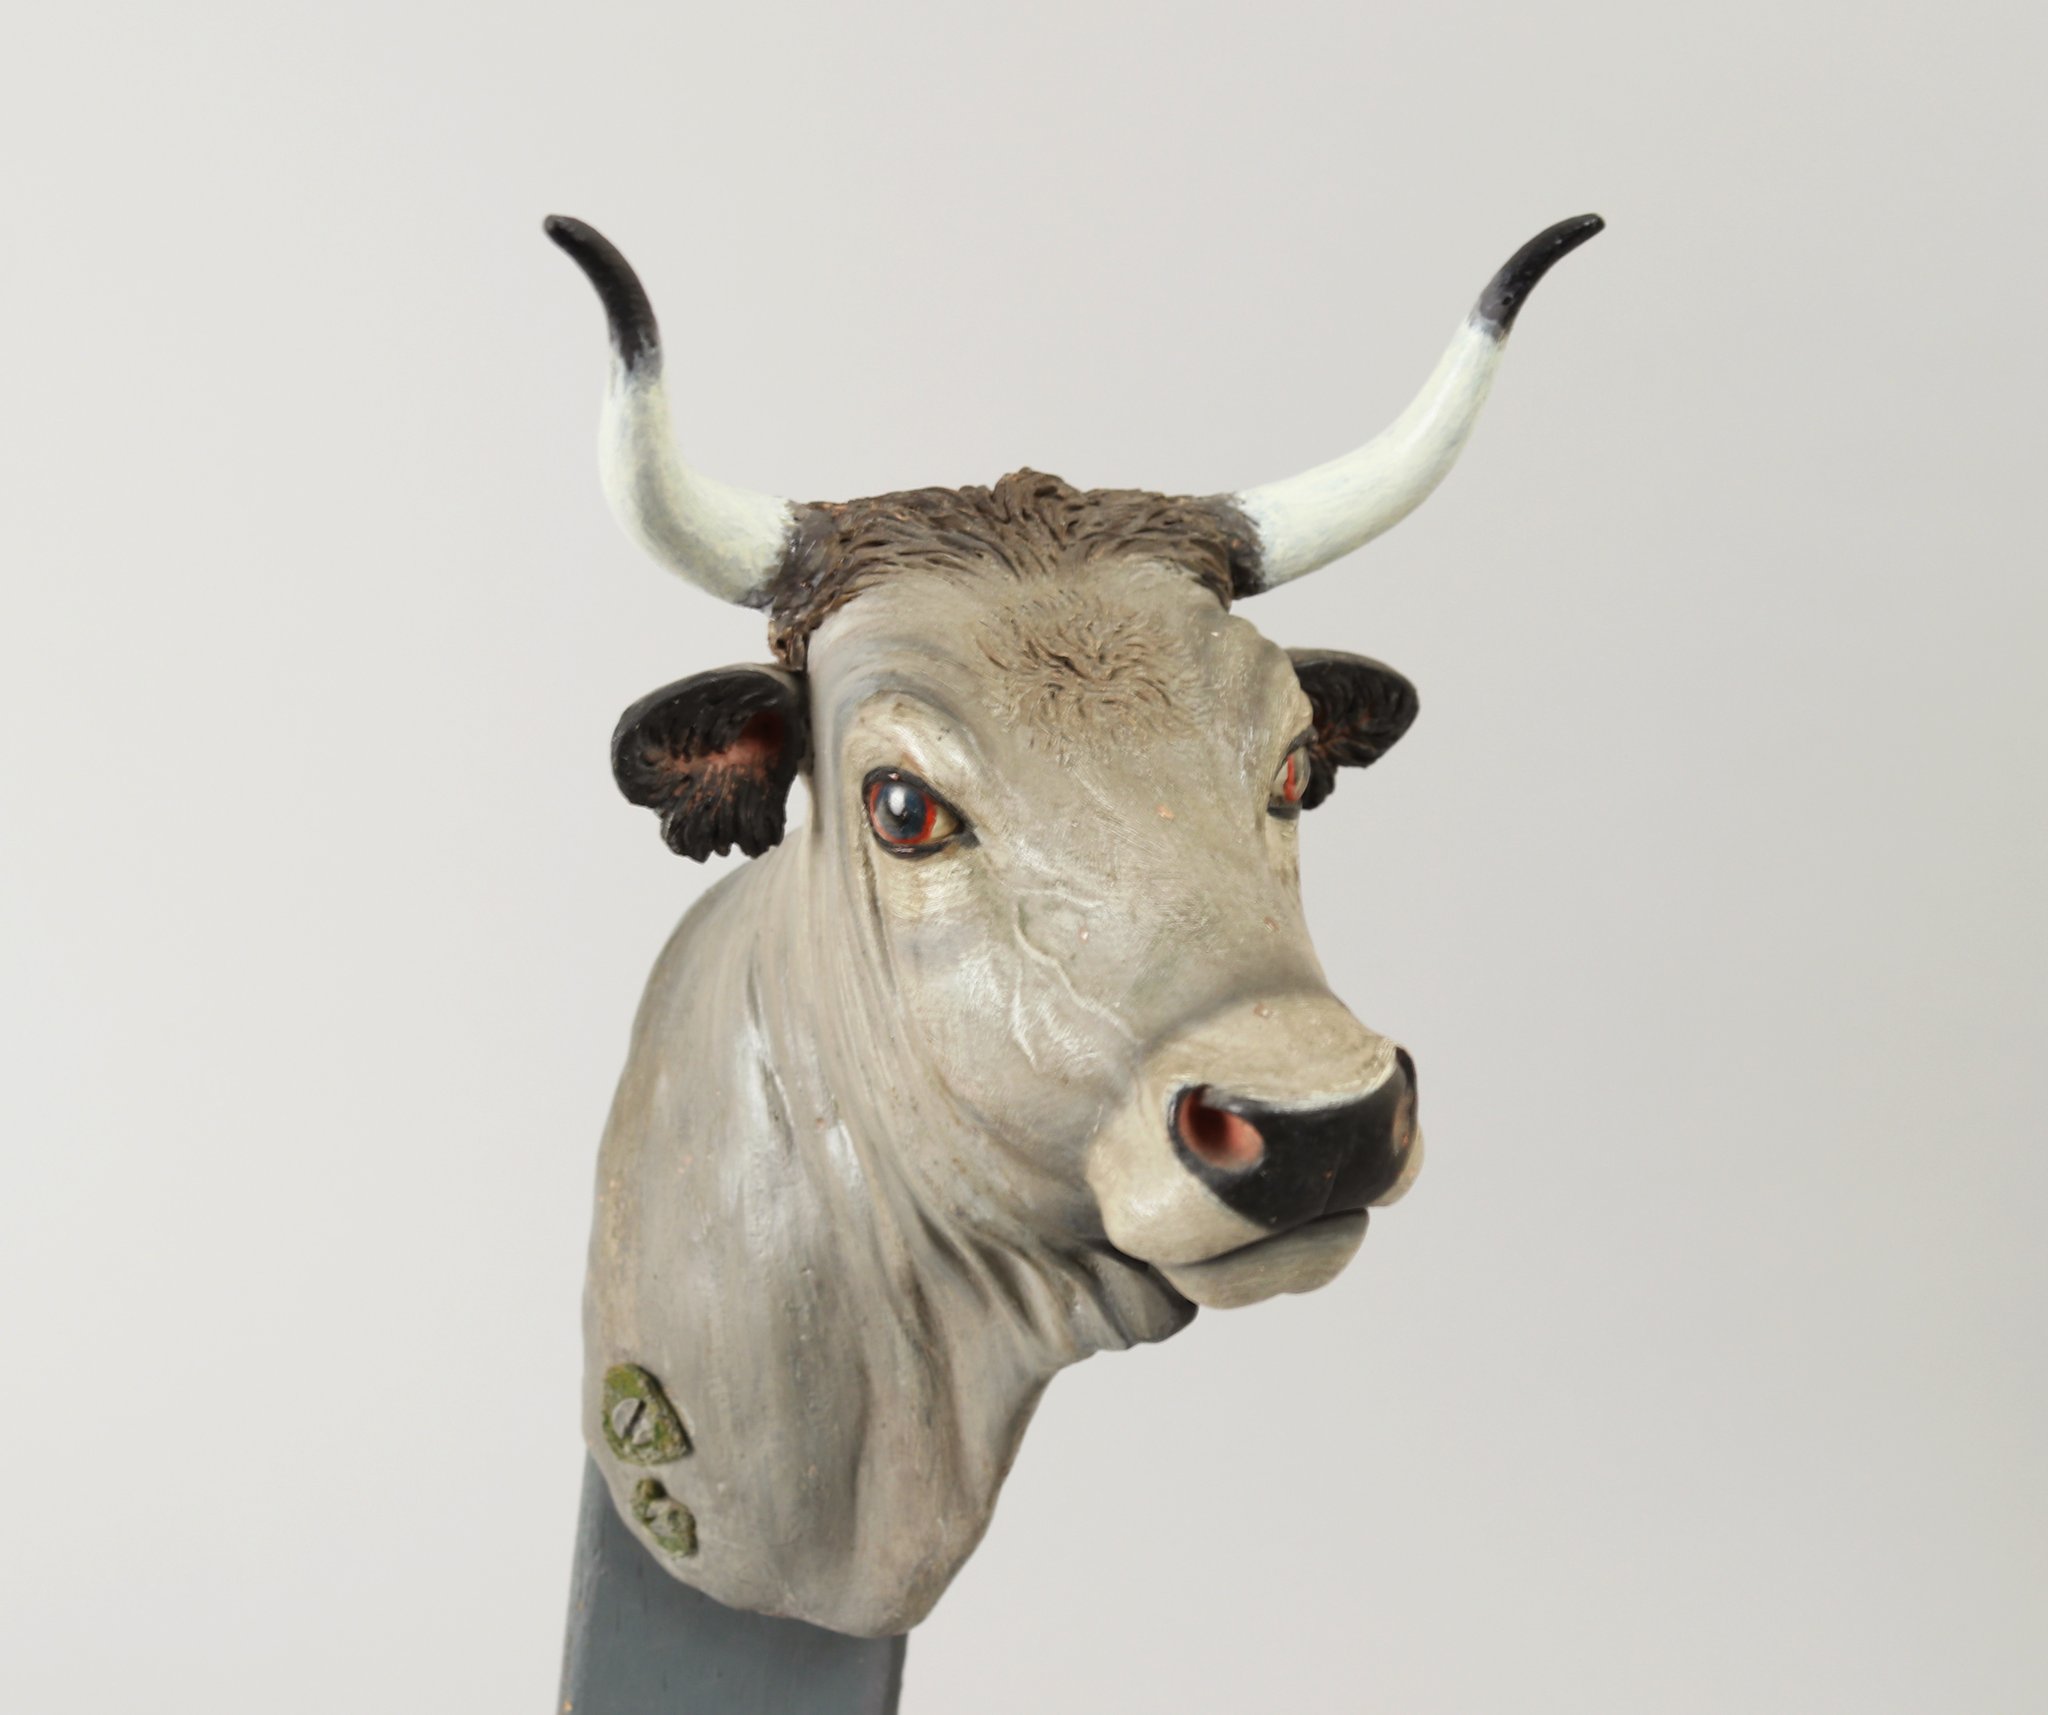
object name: crèche figure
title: Cow's head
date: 1751-1800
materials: terracotta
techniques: polychrome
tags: cows